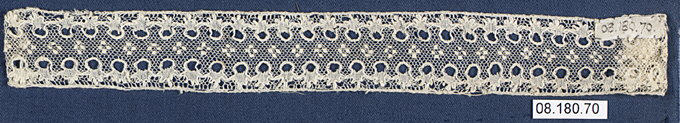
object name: insertion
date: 1801-1900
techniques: lace